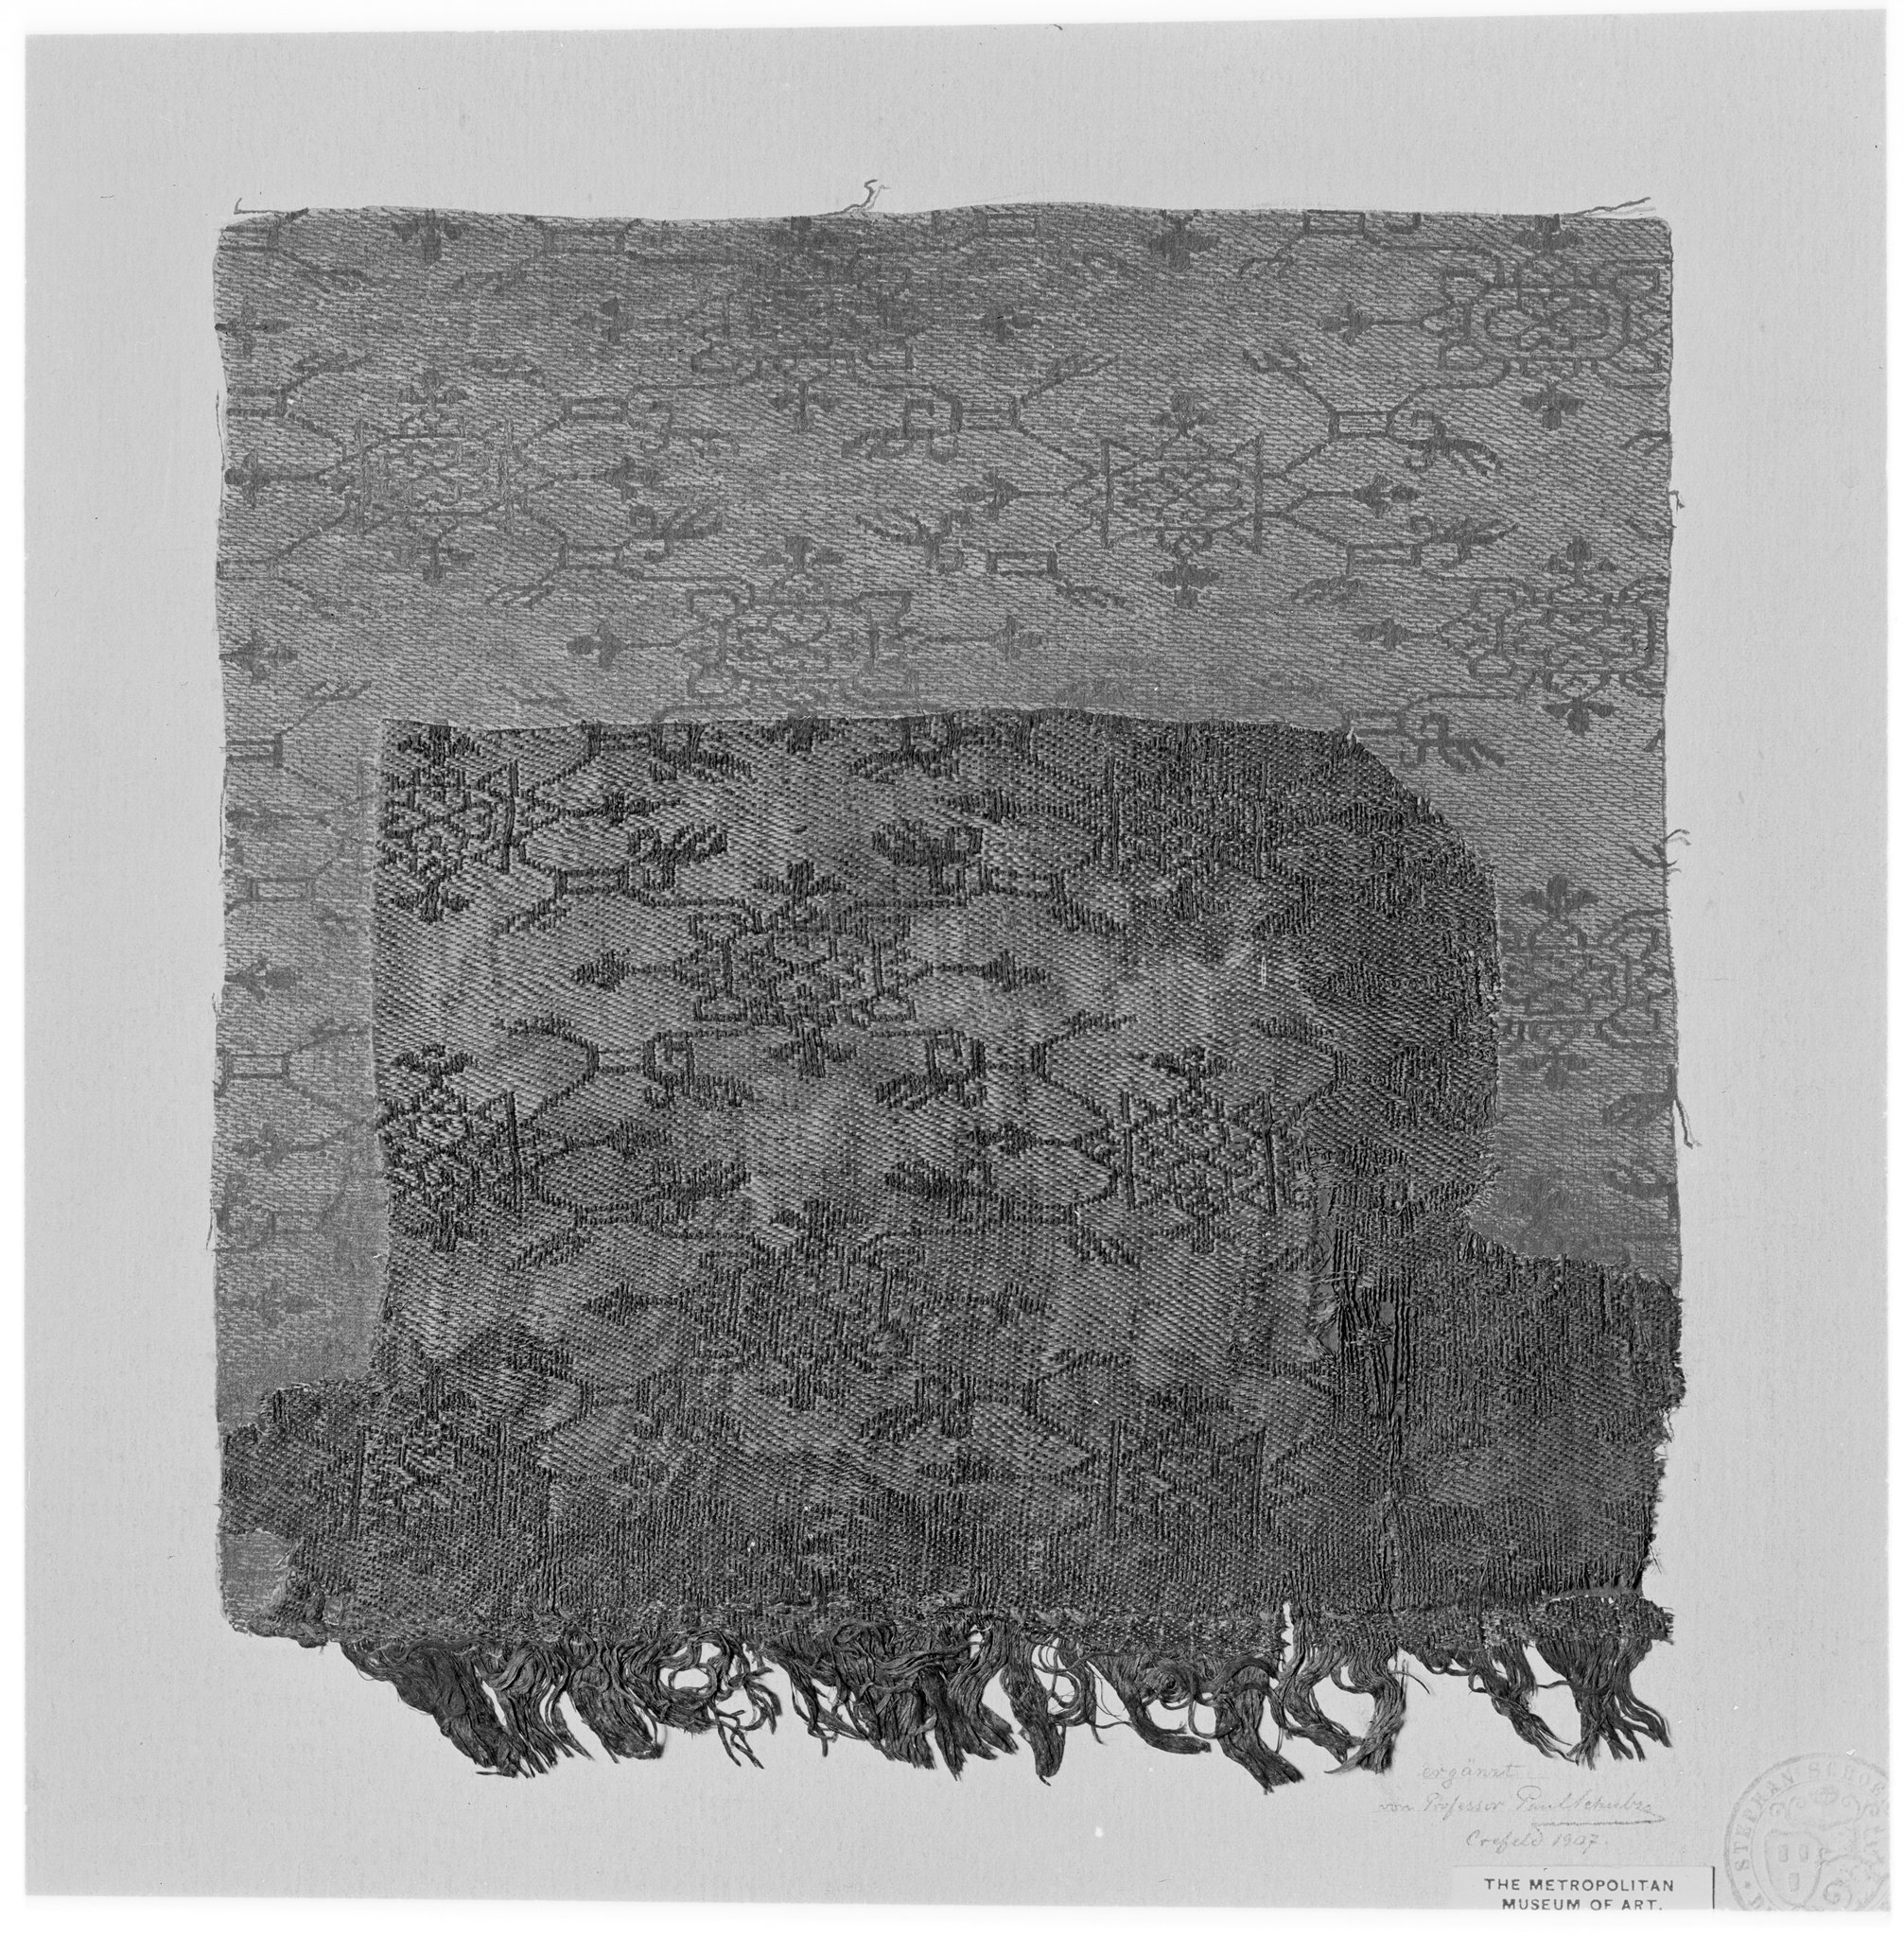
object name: textile fragment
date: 801-1000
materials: silk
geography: egypt